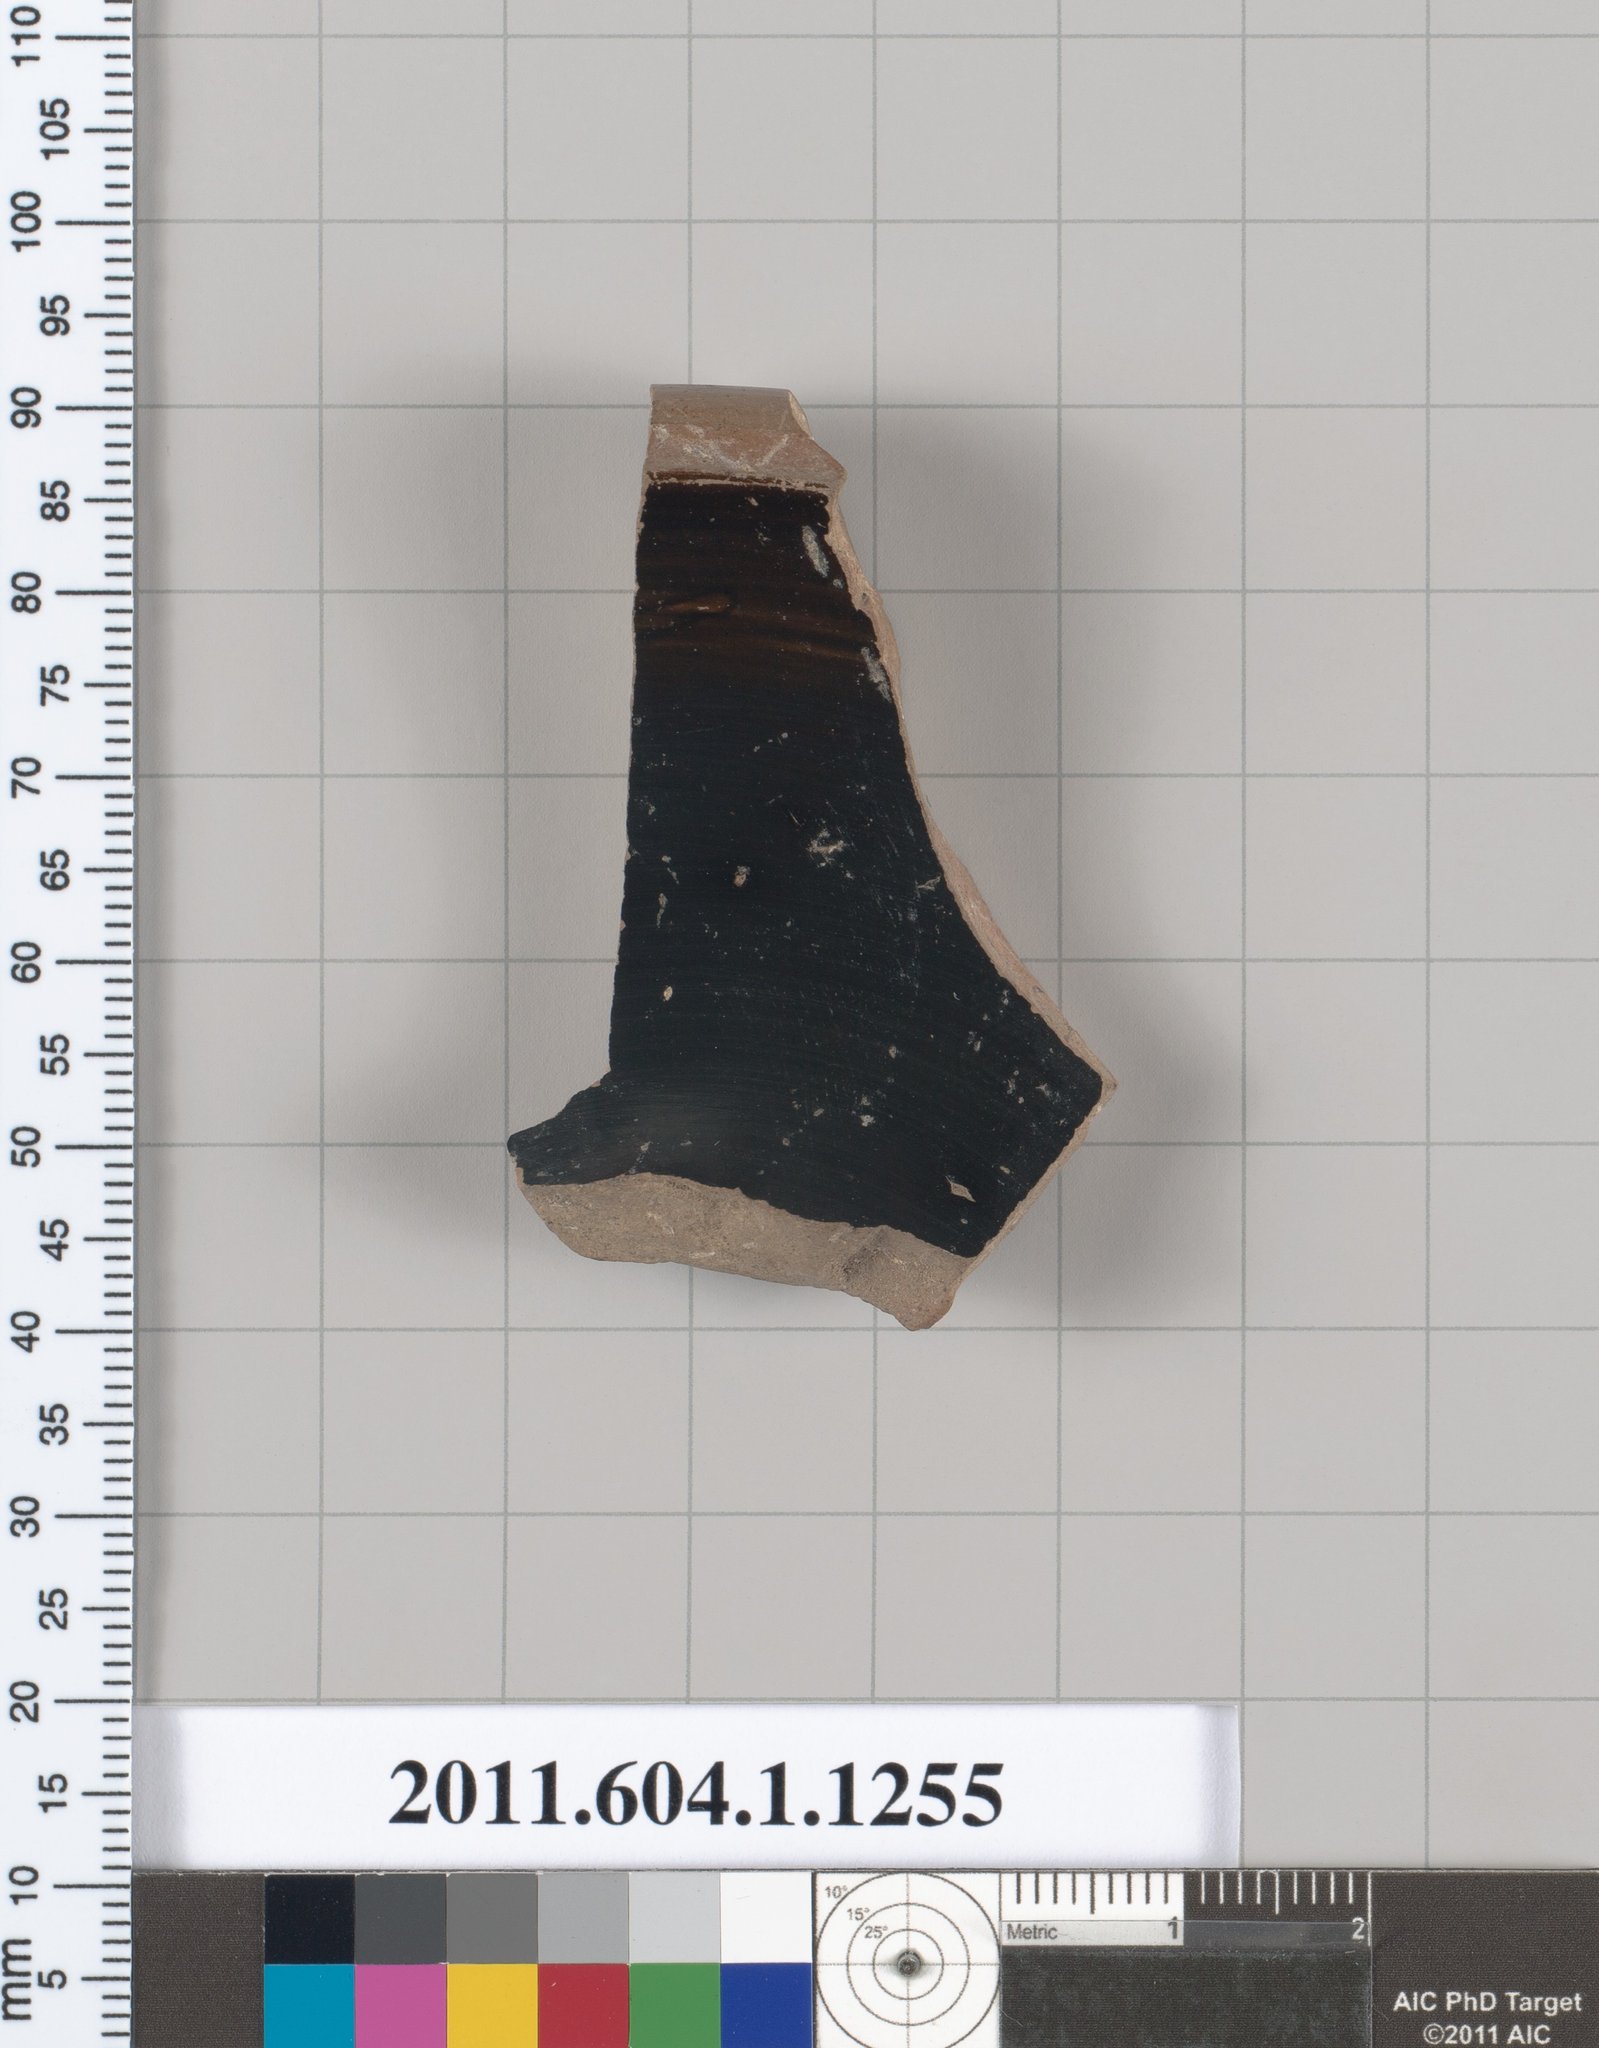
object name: kylix fragment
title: Terracotta fragment of a kylix (drinking cup)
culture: greek, attic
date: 500-401 BCE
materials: terracotta